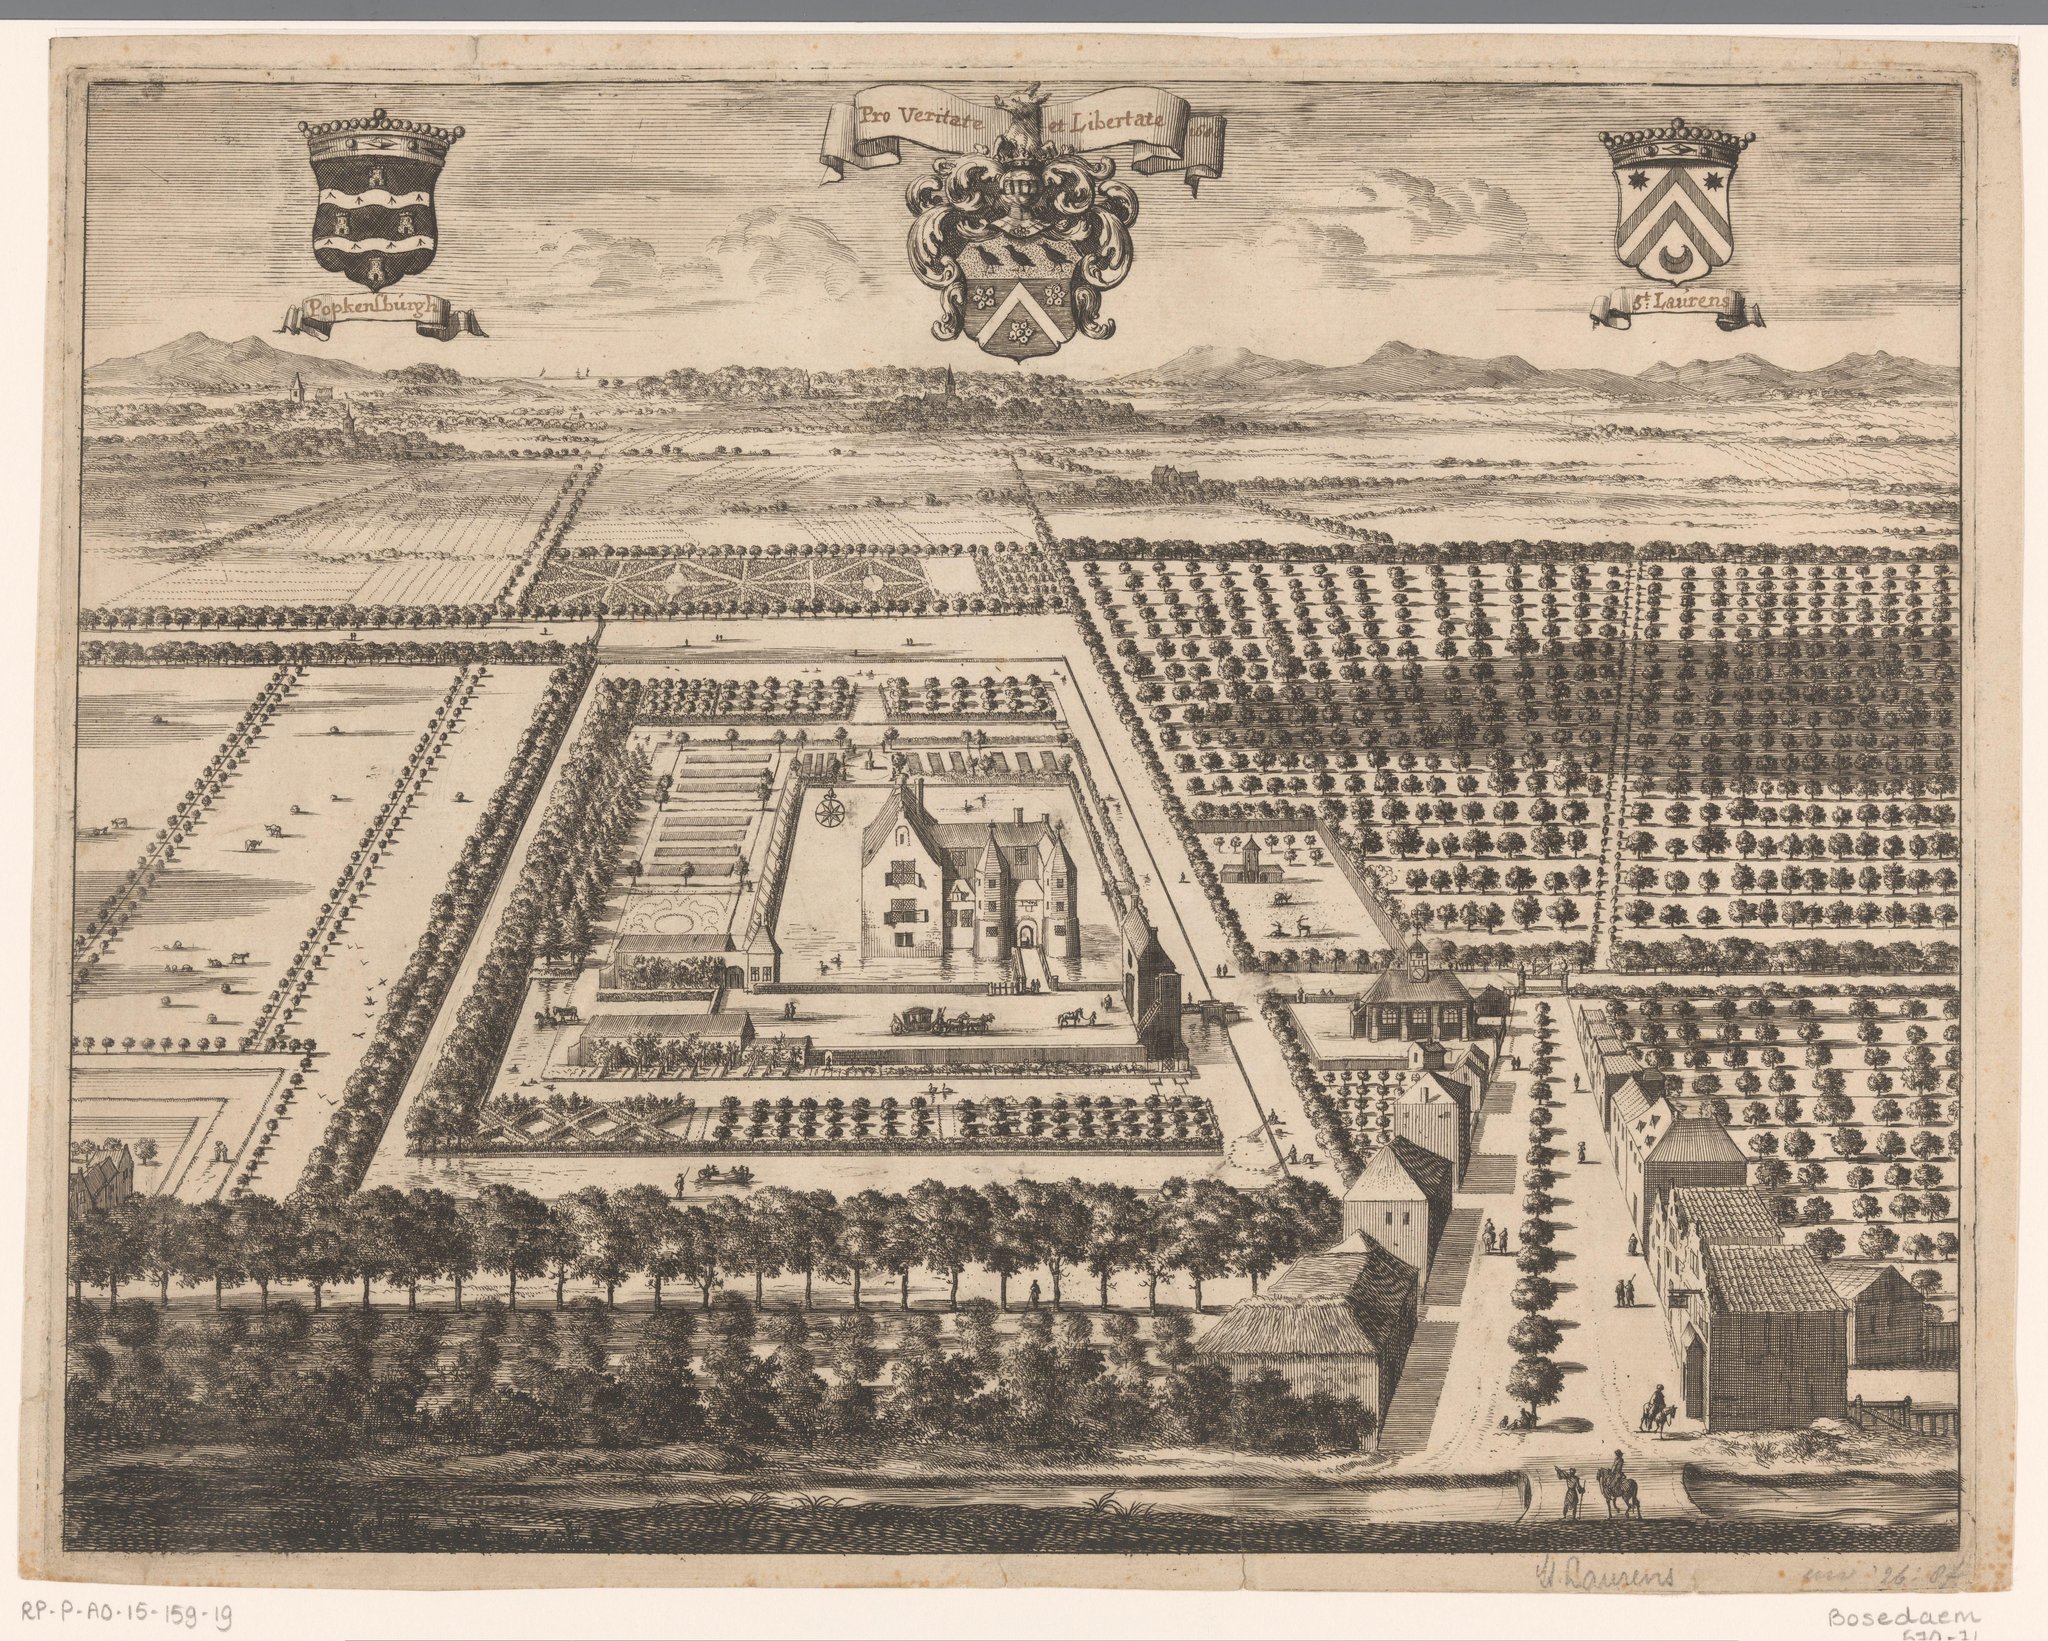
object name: print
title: Gezicht op Kasteel Popkensburg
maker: jan luyken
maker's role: draughtsman, print maker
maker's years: 1649-1712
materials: ink, paper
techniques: engraving, etching, pen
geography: amsterdam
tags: prospect of village, silhouette of village, coat of arms (as symbol of the state, etc.) (+ city; municipal), castle, french or architectonic garden; formal garden, orchard, armorial bearing, heraldry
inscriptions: inscription: ‘Popkensburgh’, inscription: ‘St. Laurens’, inscription: ‘Pro Veritate et Liberate 1688’, collector's mark: Lugt 195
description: Gezicht op Kasteel Popkensburg te Sint Laurens op Walcheren, in vogelvluchtperspectief. In het midden het kasteel, daaromheen de tuinen en boomgaarden. Linksboven het wapen van Popkensburg, in het midden het wapen van eigenaar Johan Boudaen Courten, rechtsboven het wapen van Sint Laurens.